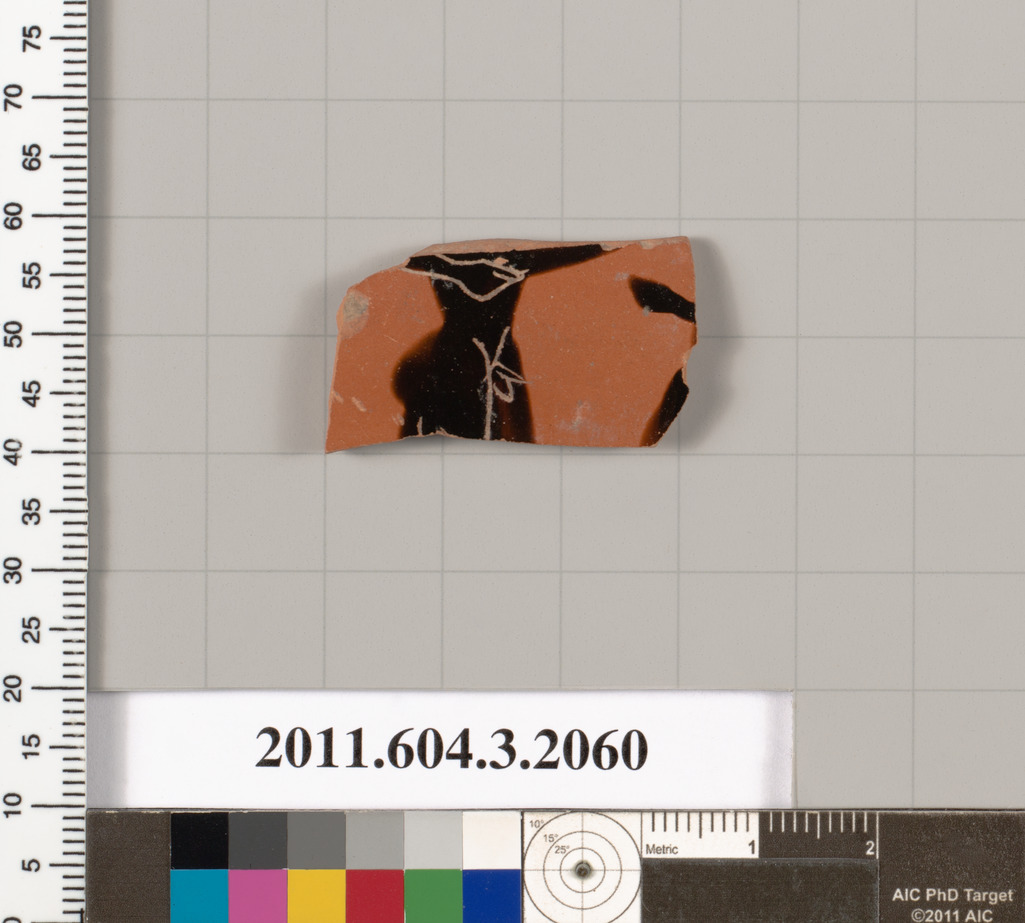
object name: kylix fragment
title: Terracotta fragment of a kylix (drinking cup)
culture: greek, attic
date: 534-468 BCE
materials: terracotta